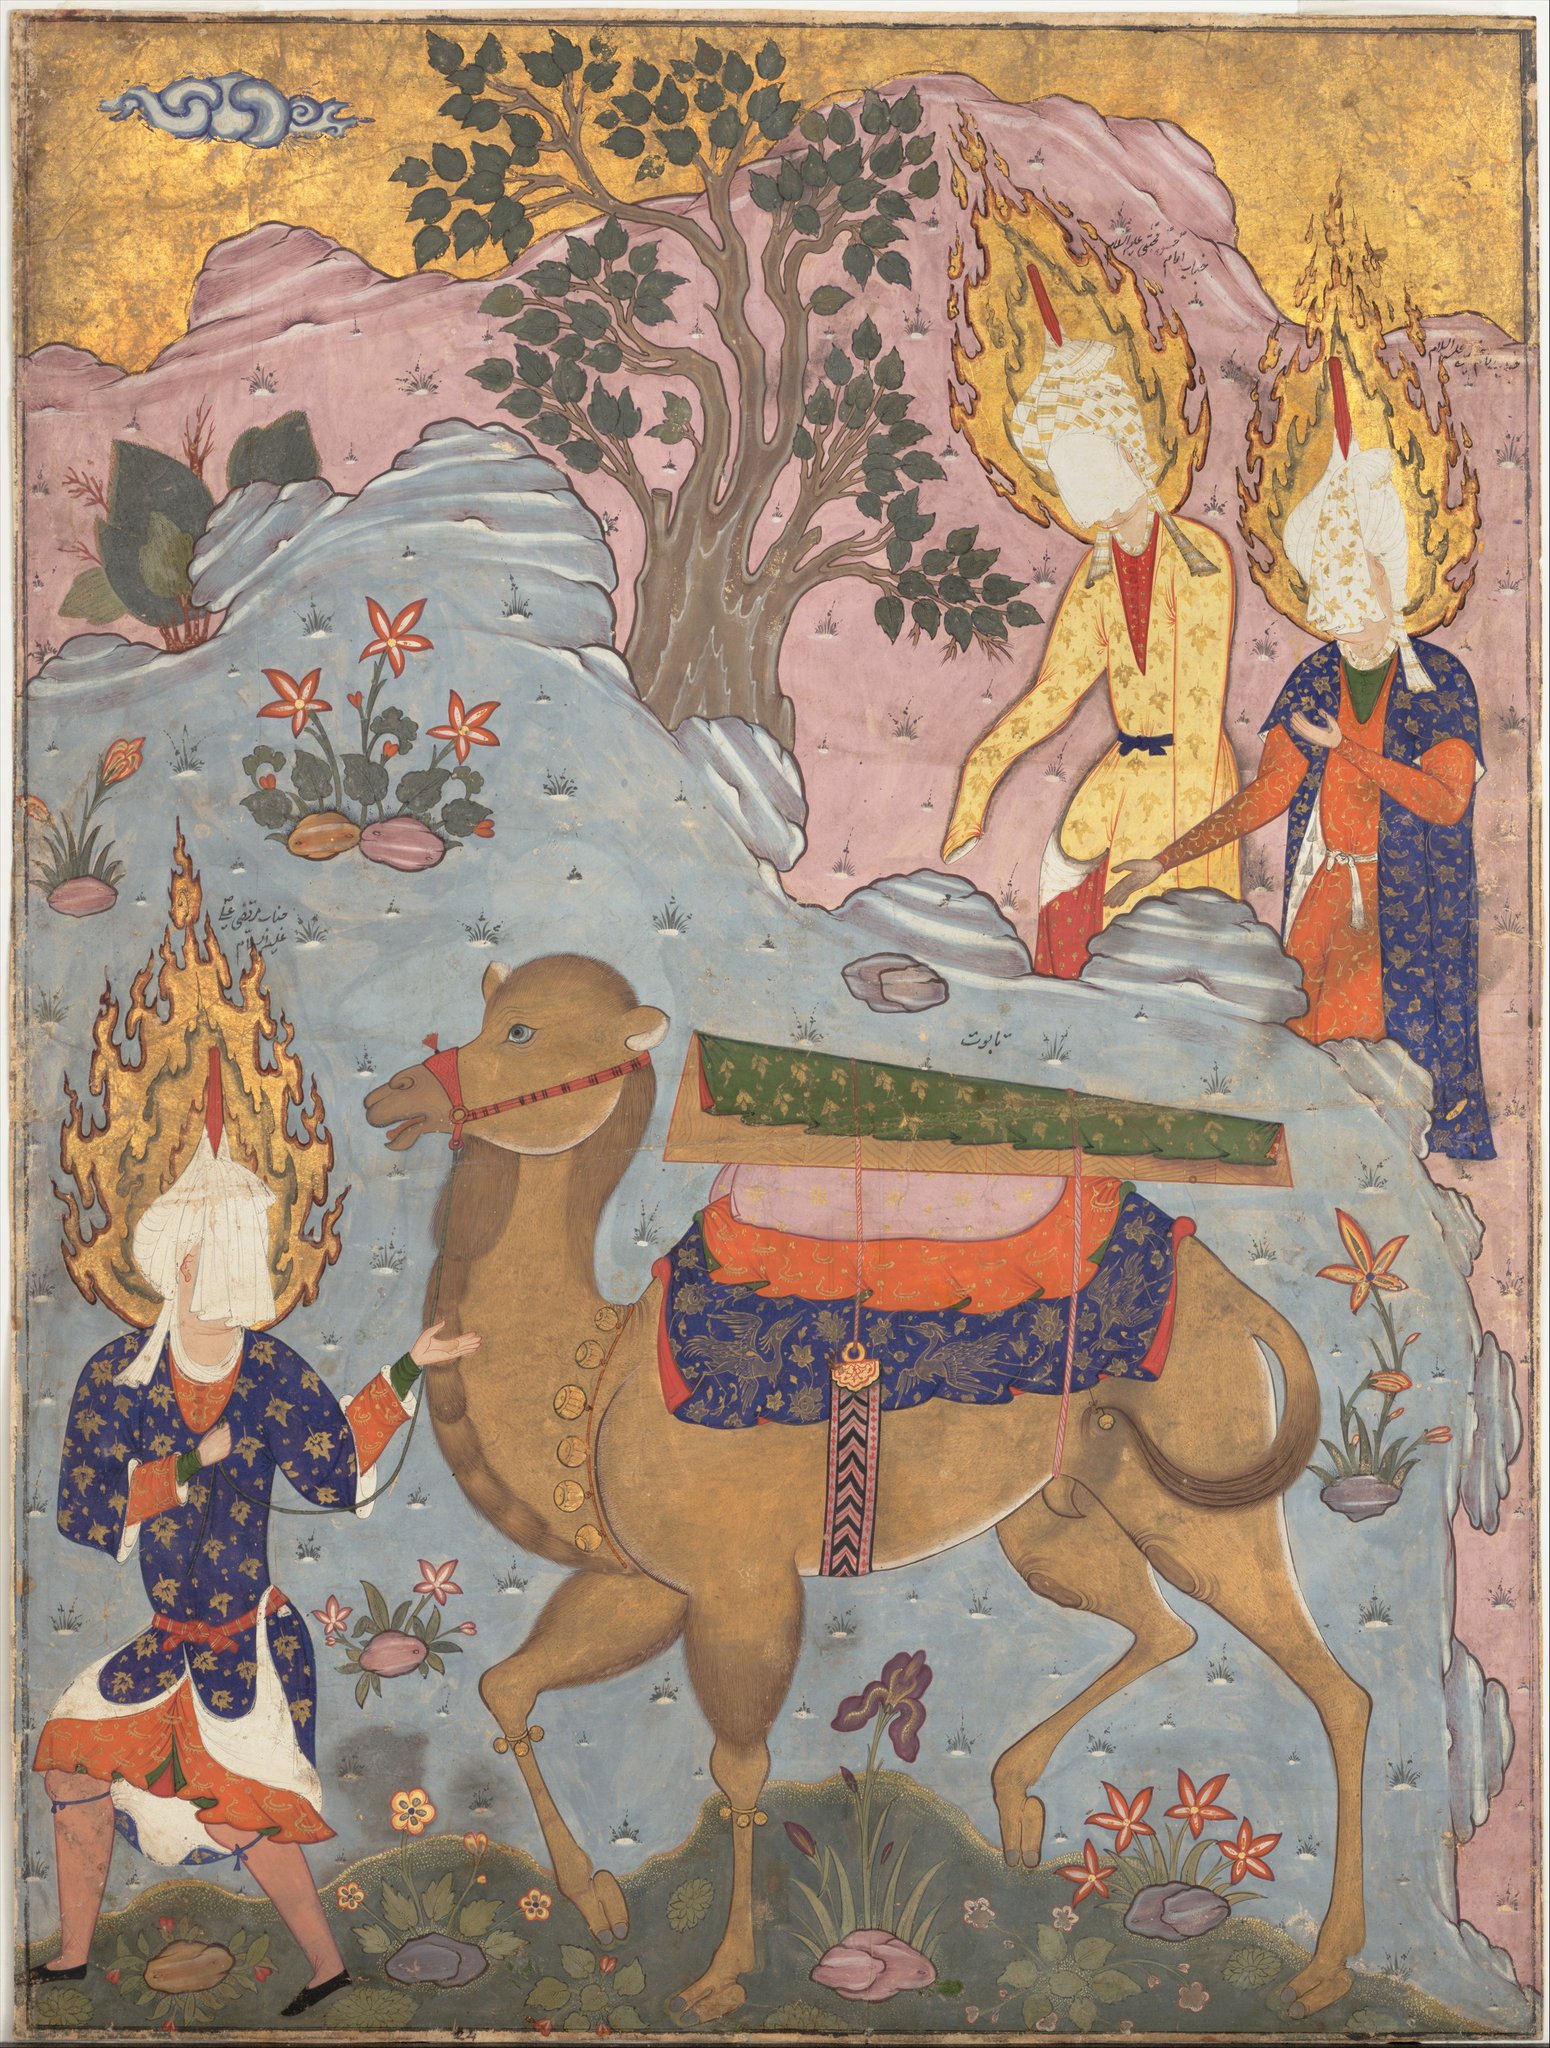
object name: folio from an illustrated manuscript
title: "Coffin of Imam 'Ali", Folio from a Falnama (The Book of Omens) of Ja'far al-Sadiq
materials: gold, ink, paper, watercolor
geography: iran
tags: men,camels,hills